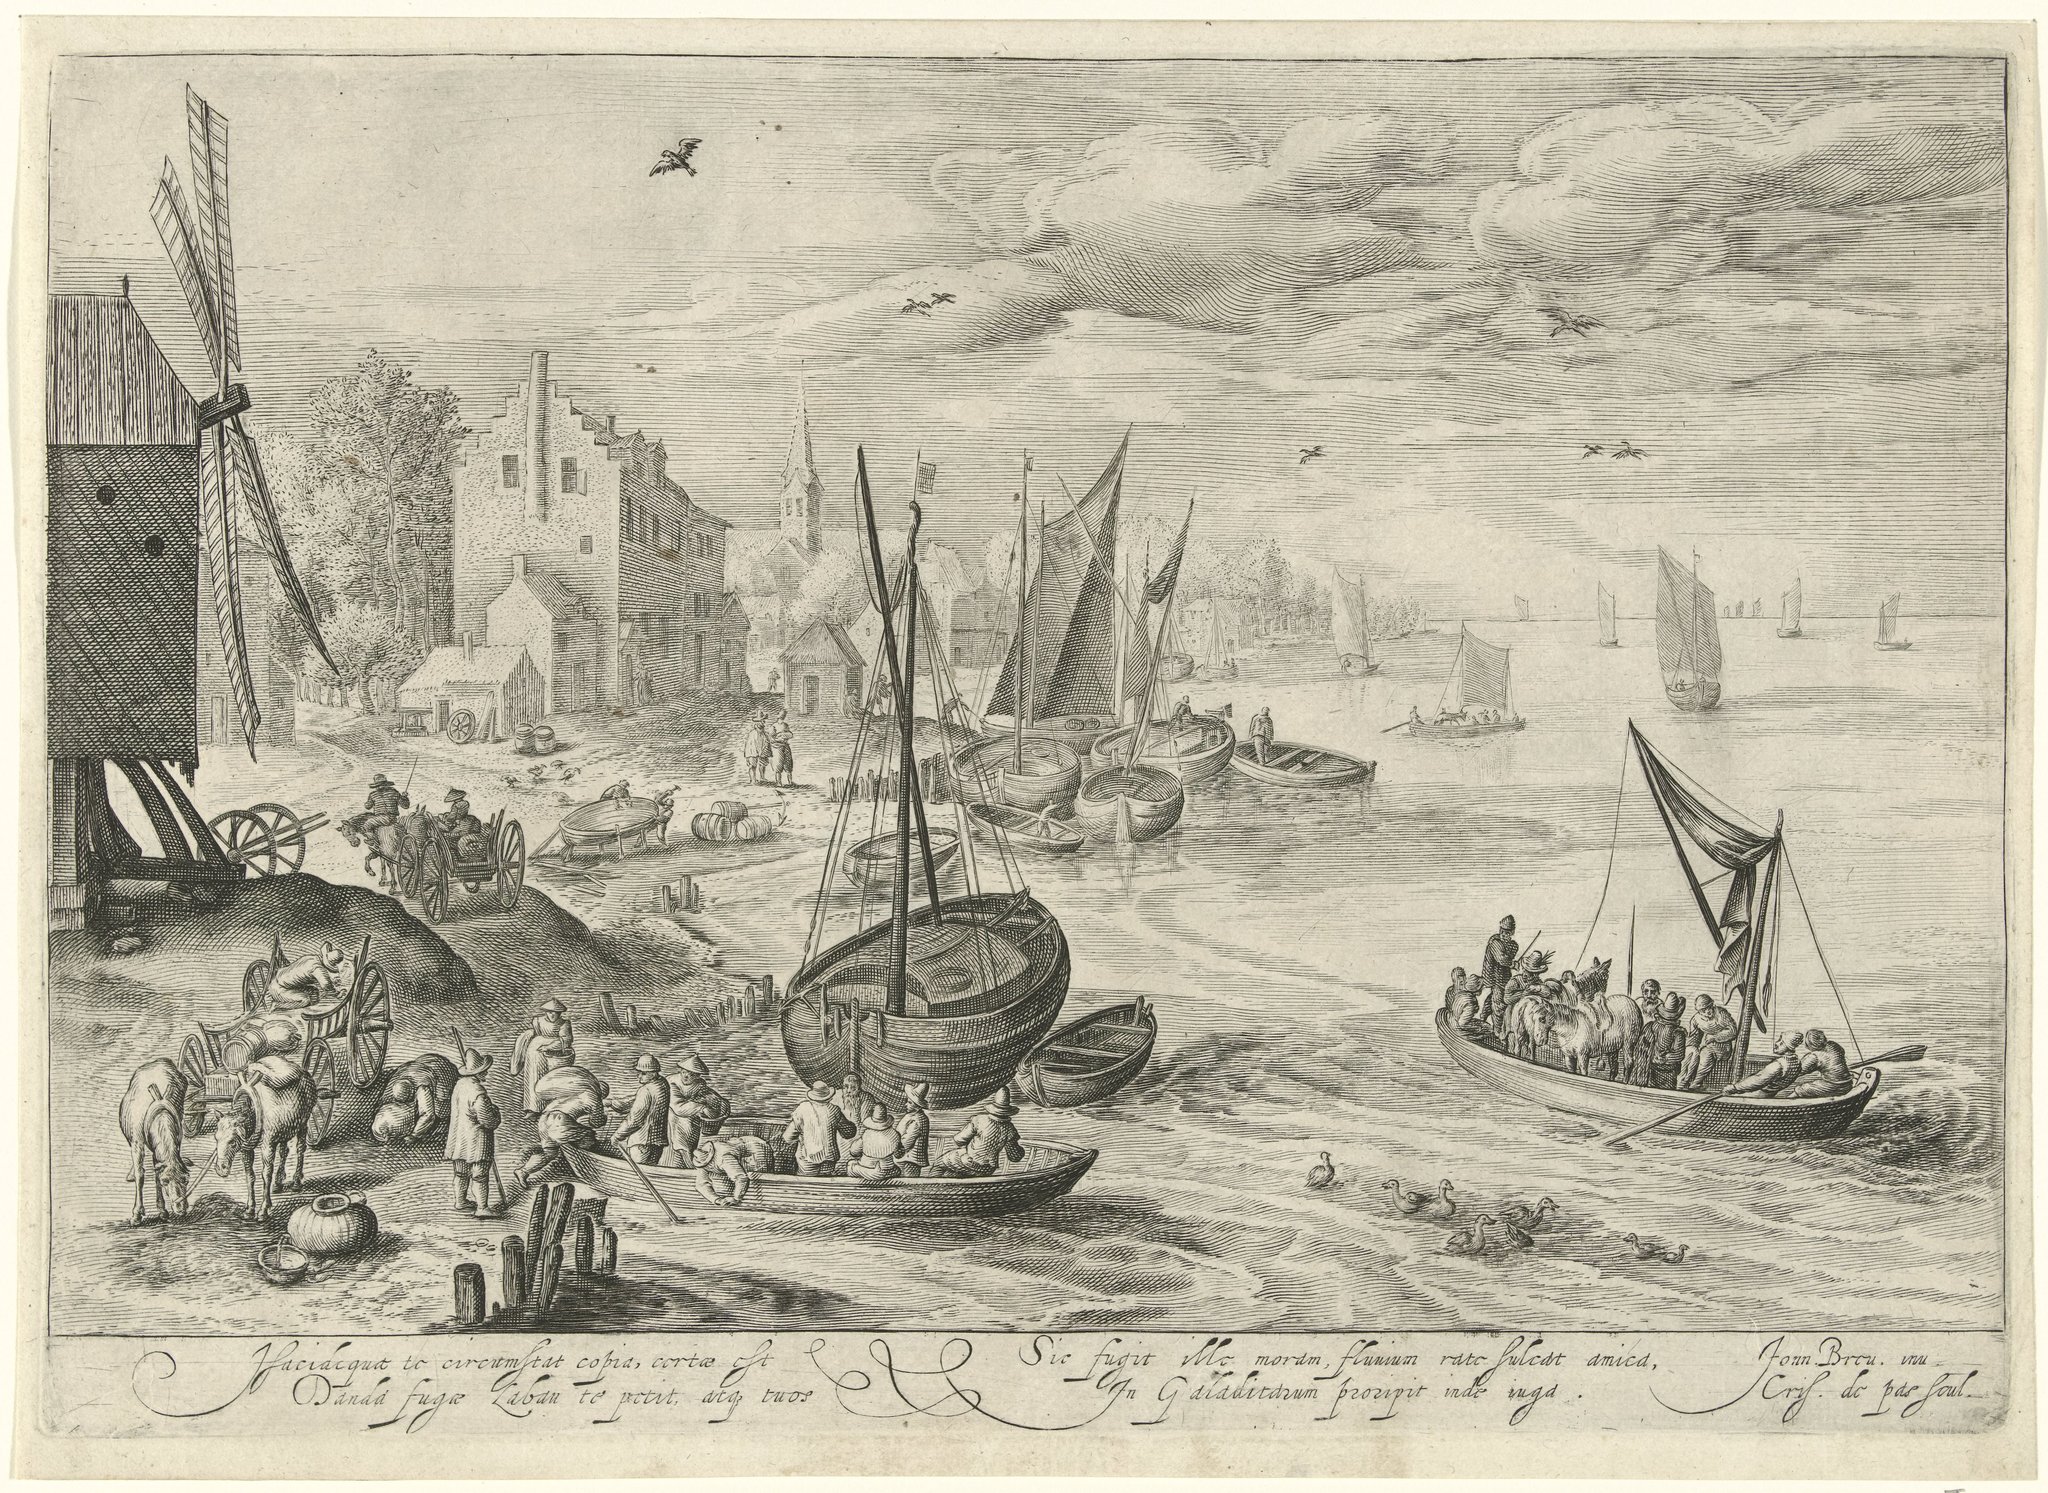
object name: print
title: Landschappen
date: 1580-1588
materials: paper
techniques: engraving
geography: antwerp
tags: river, village, windmill, water-birds: duck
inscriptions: collector's mark: Lugt 538, collector's mark: Lugt 2228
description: Landschap met een dorp aan een rivier. Links op de voorgrond een windmolen. Bij een steiger liggen diverse boten aangemeerd en op de rivier vaart een volgeladen veerboot. In de marge een vierregelig onderschrift, in twee kolommen, in het Latijn.